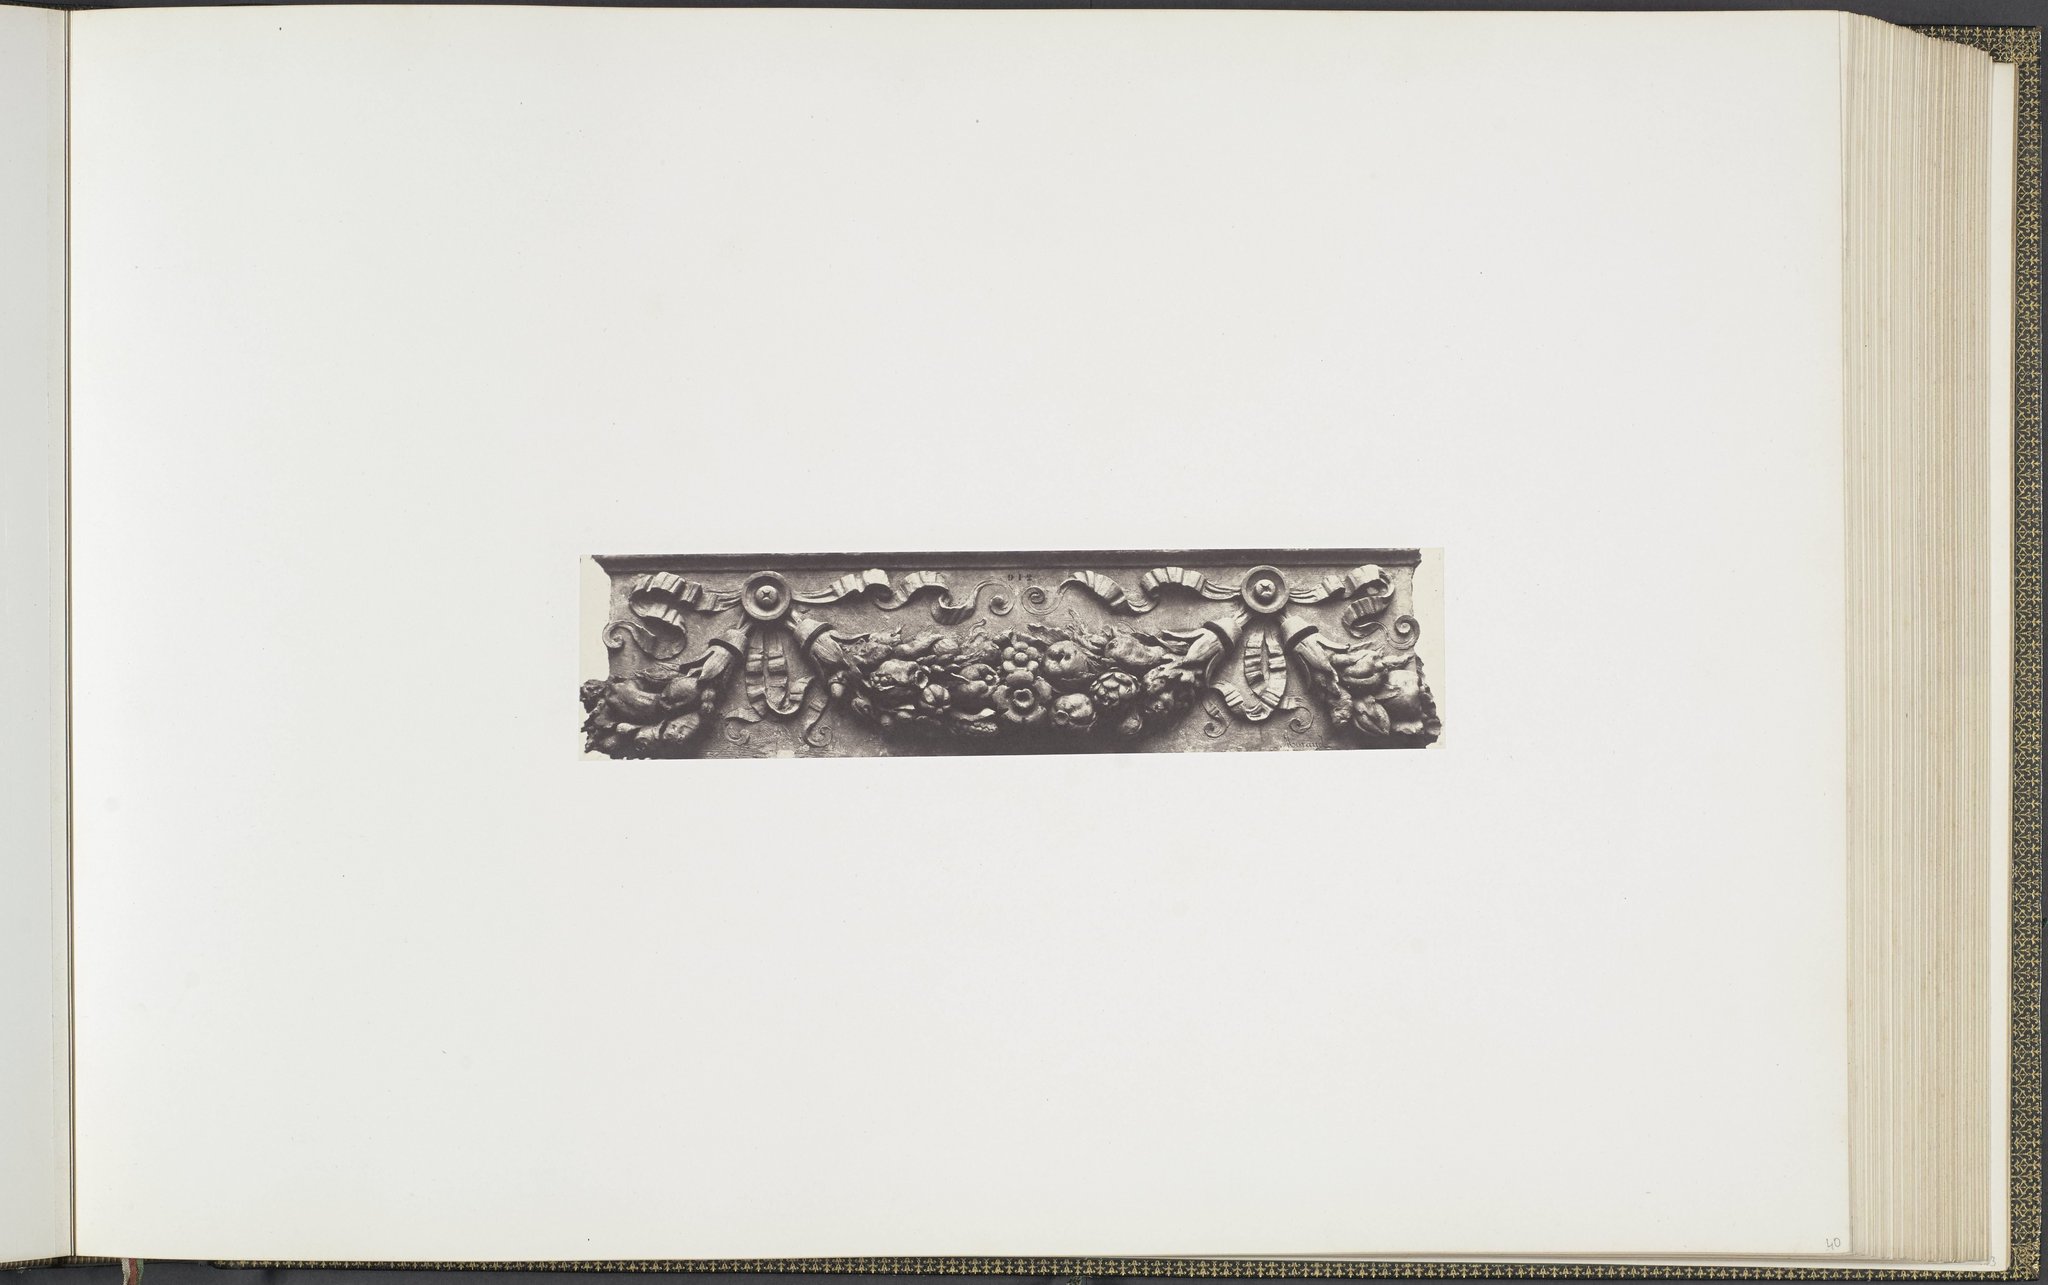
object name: album leaf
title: Detail van een gipsmodel voor de versiering van het Palais du Louvre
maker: édouard denis baldus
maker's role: fotograaf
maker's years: 1813-1889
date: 1855-1857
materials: paper, photographic support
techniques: salted paper print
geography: paris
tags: permanent exhibition, museum, ornamenting, decorating ~ applied arts, paris, tuileries palace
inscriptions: number: ‘394’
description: Onderdeel van Réunion des Tuileries au Louvre 1852-1857, album 1.